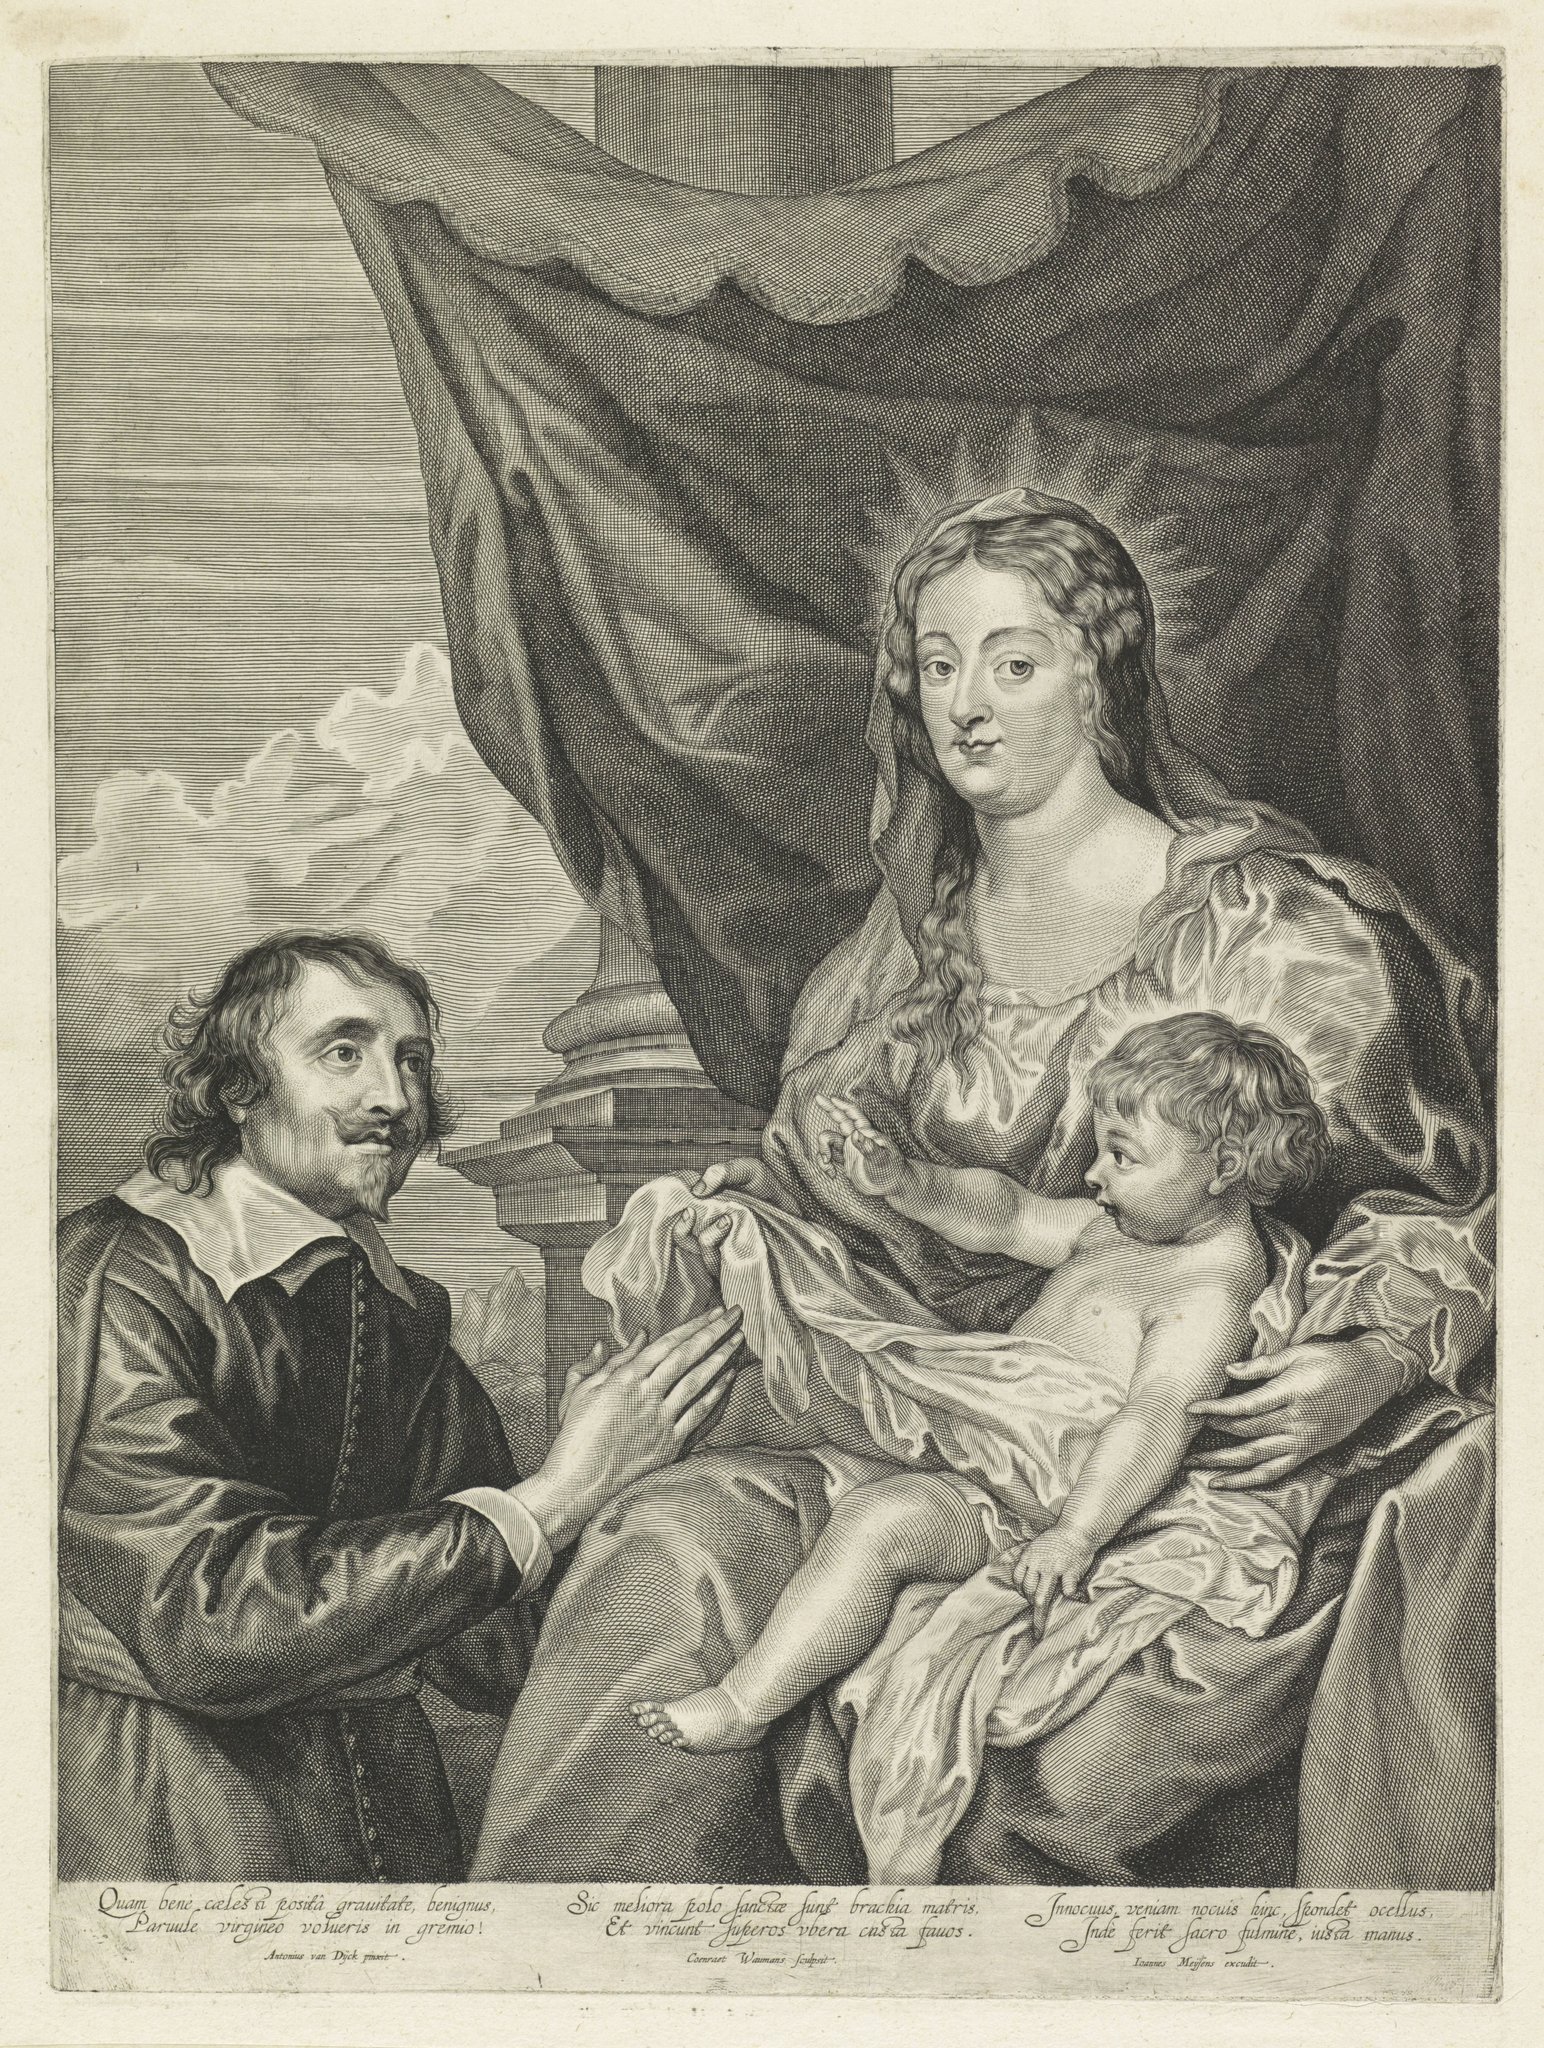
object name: print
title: Maria en het Christuskind aanbeden door Cesare Alessandro Scaglia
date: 1633-1673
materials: paper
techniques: engraving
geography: antwerp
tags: madonna: mary sitting or enthroned, the christ-child in her lap (or in front of her bosom) (mary sometimes represented half-length), mary together with mortals, who adore her, or implore her to help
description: Cesare Alessandro Scaglia knielt in aanbidding voor Maria en het Christuskind. Het Kind zegent hem. In de marge een zesregelig onderschrift, in drie kolommen, in het Latijn.